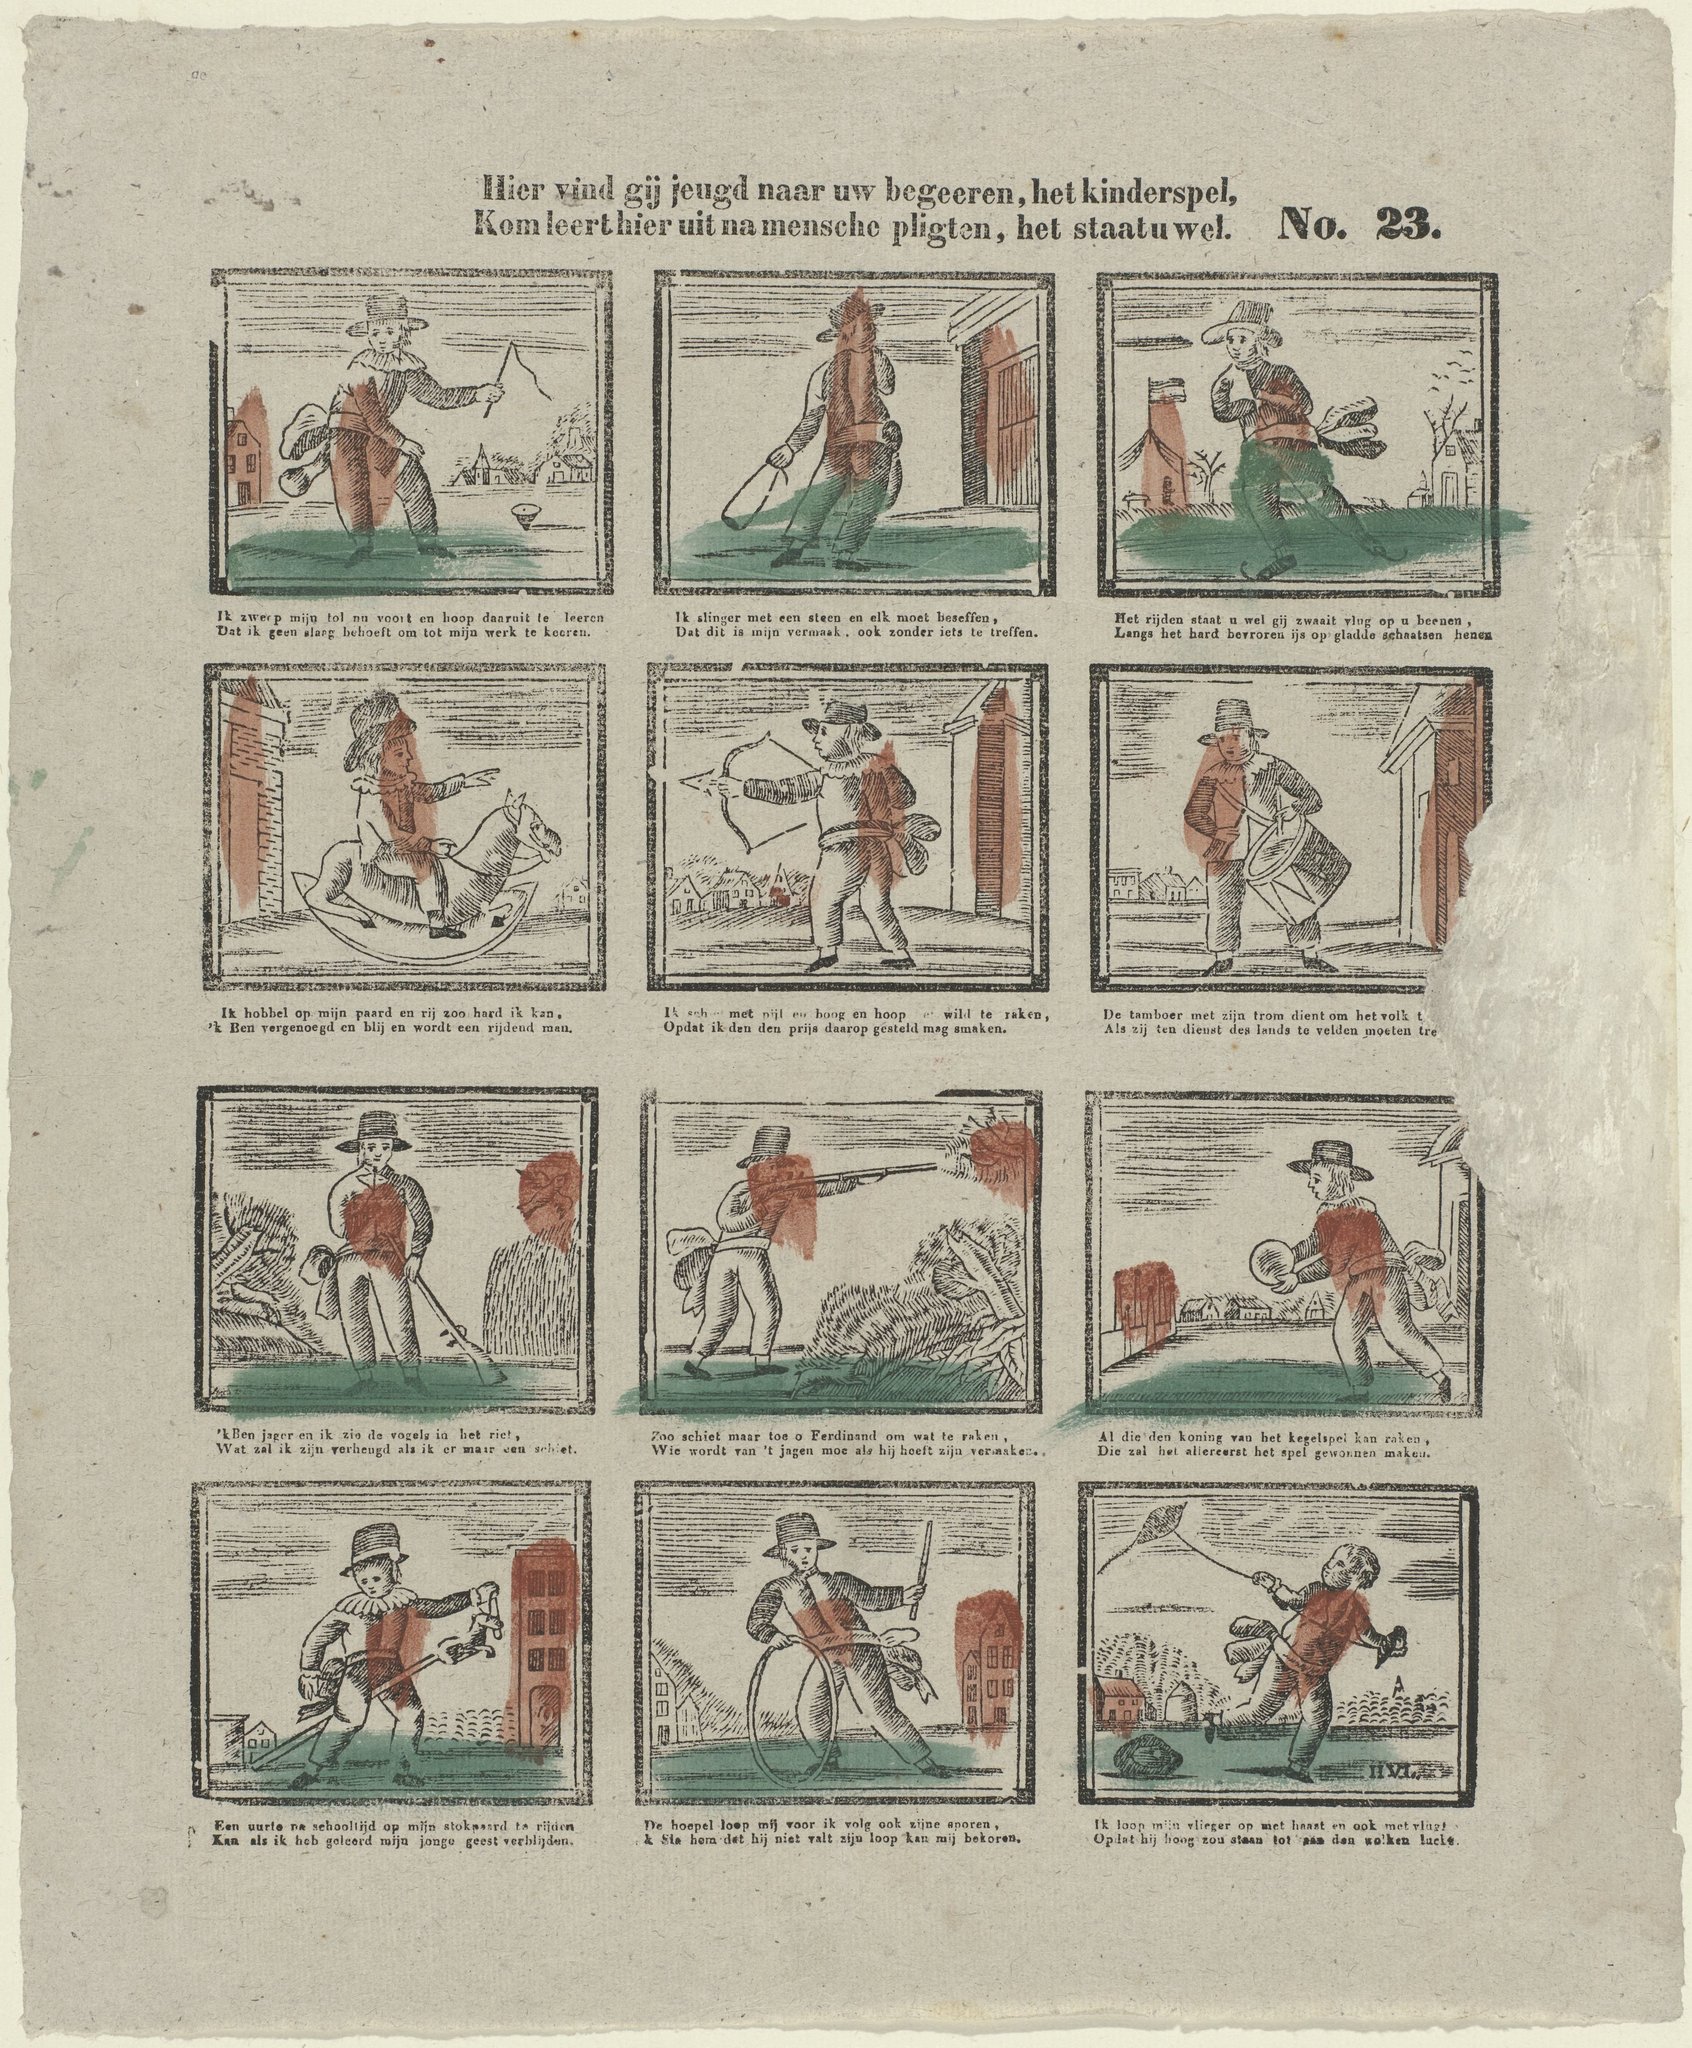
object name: print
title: Hier vind gij jeugd naar uw begeeren, het kinderspel, / Kom leert hier uit na mensche pligten, het staat u wel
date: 1832-1850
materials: paper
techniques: colour, letterpress printing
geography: rotterdam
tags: children's games and plays, skates (winter sports), (flying a) kite, games using special objects (marbles, top, hoop, etc.)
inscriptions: collector's mark: Lugt 2760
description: Blad met 12 voorstellingen van kinderspelen, waaronder tollen, schaatsen en trommelen. Onder elke afbeelding een tweeregelig vers. Genummerd rechtsboven: No. 23.